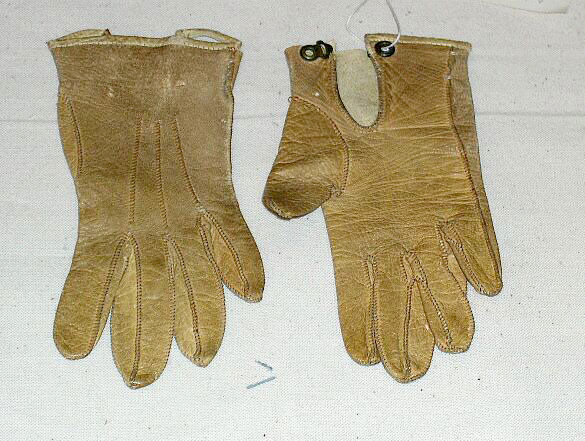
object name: glove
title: Gloves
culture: american or european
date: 1834-1866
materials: leather